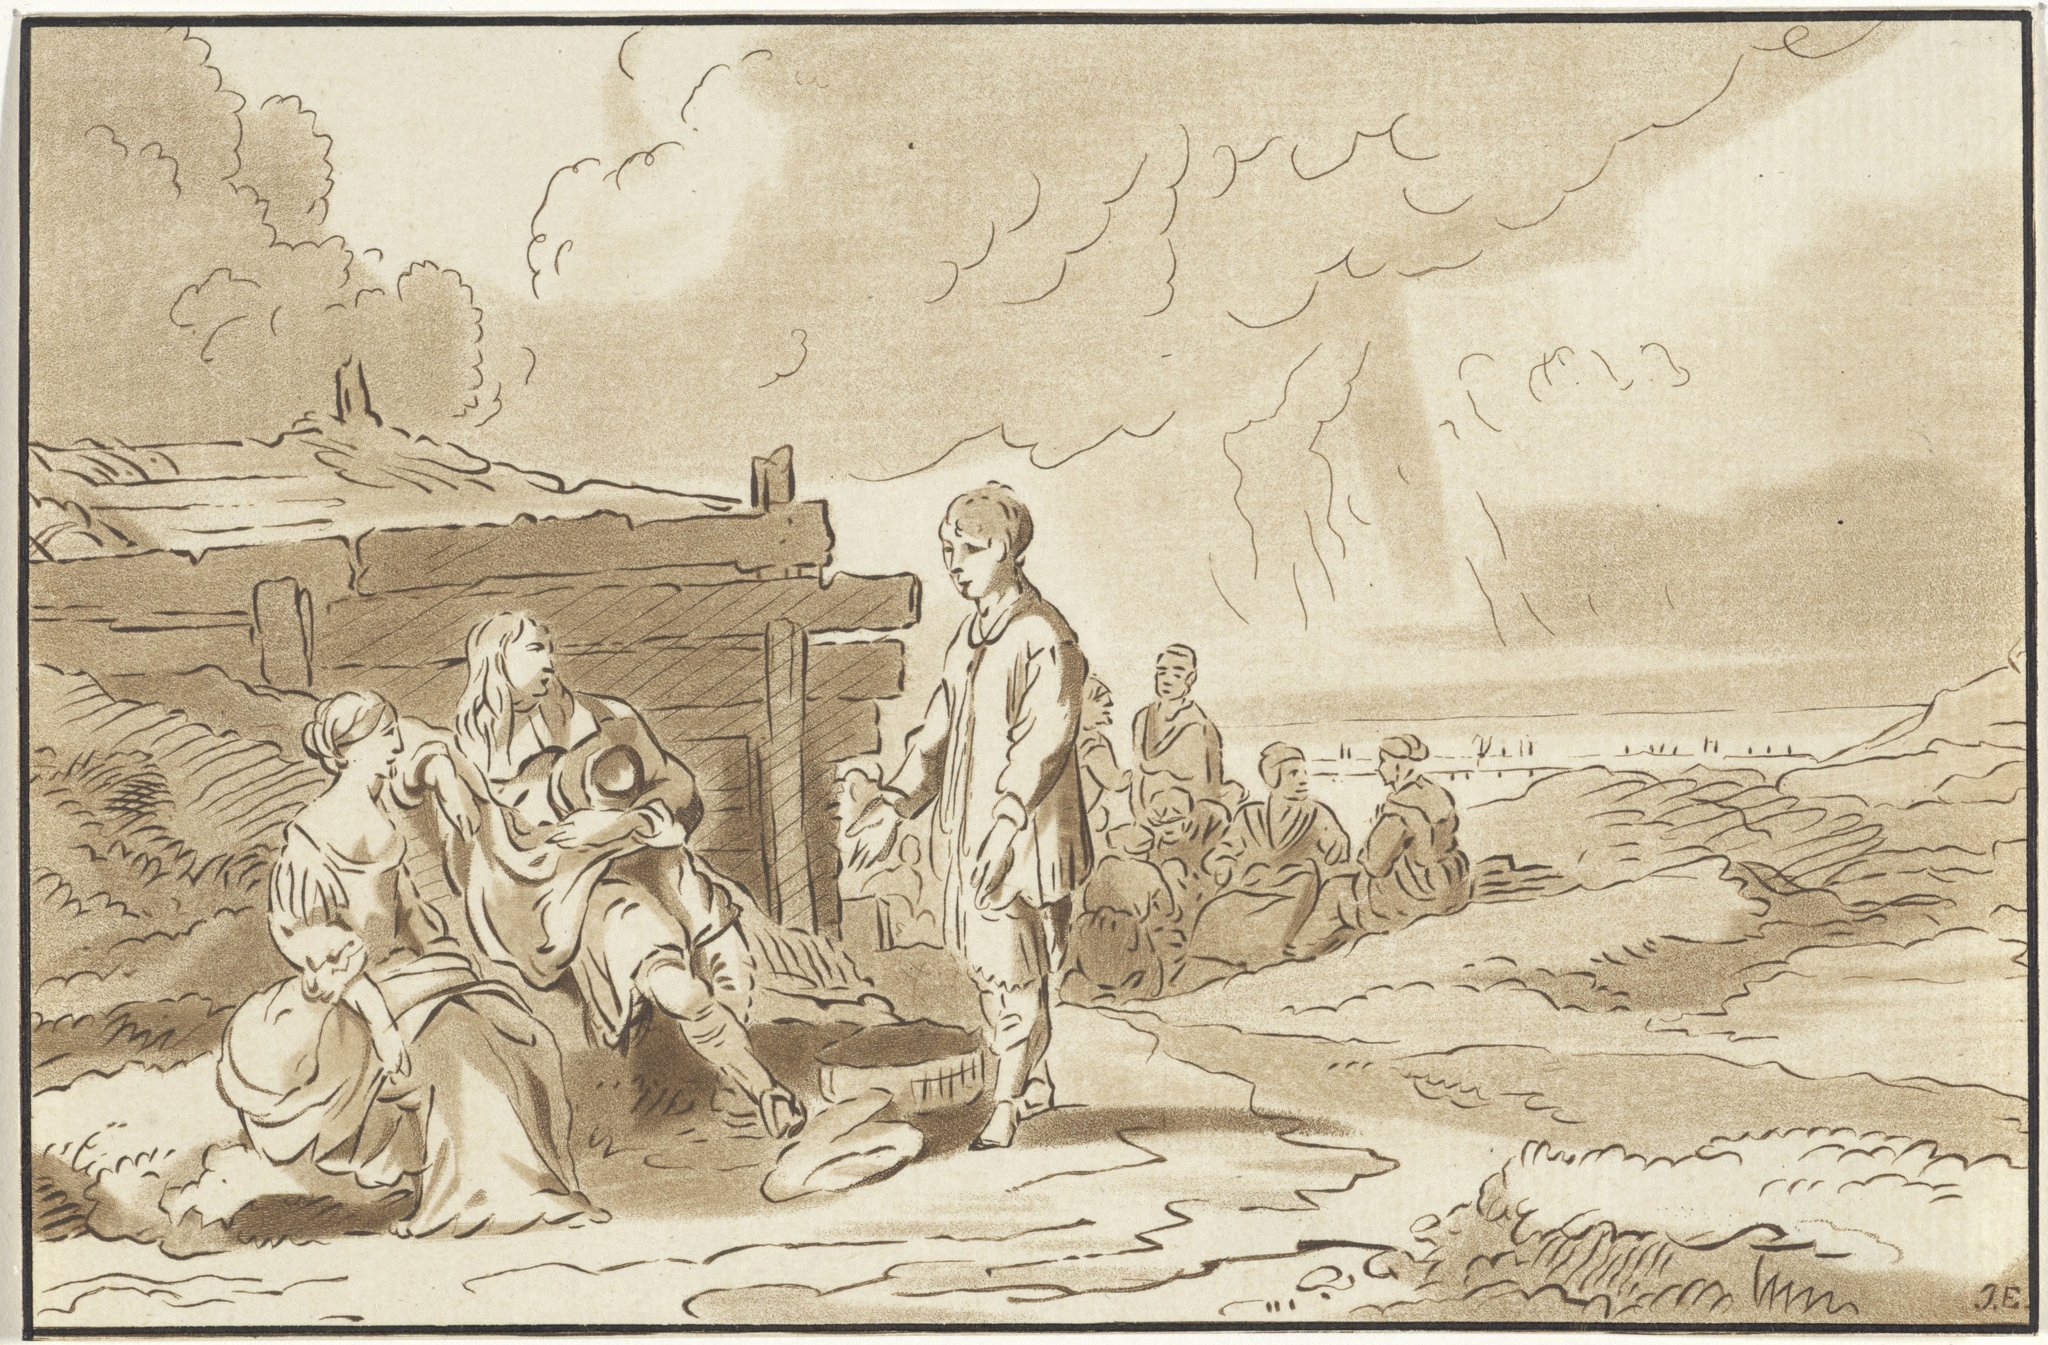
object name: print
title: Gezelschap in de duinen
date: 1767-1780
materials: paper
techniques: etching, rocker stamped, roulette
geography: netherlands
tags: recreation in the dunes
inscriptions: collector's mark: Lugt 2228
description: Bij een schutting zitten een man en een vrouw. Zij spreken met een jongen die bij hen staat. Op de achtergrond zit een andere groep mensen in de duinen.